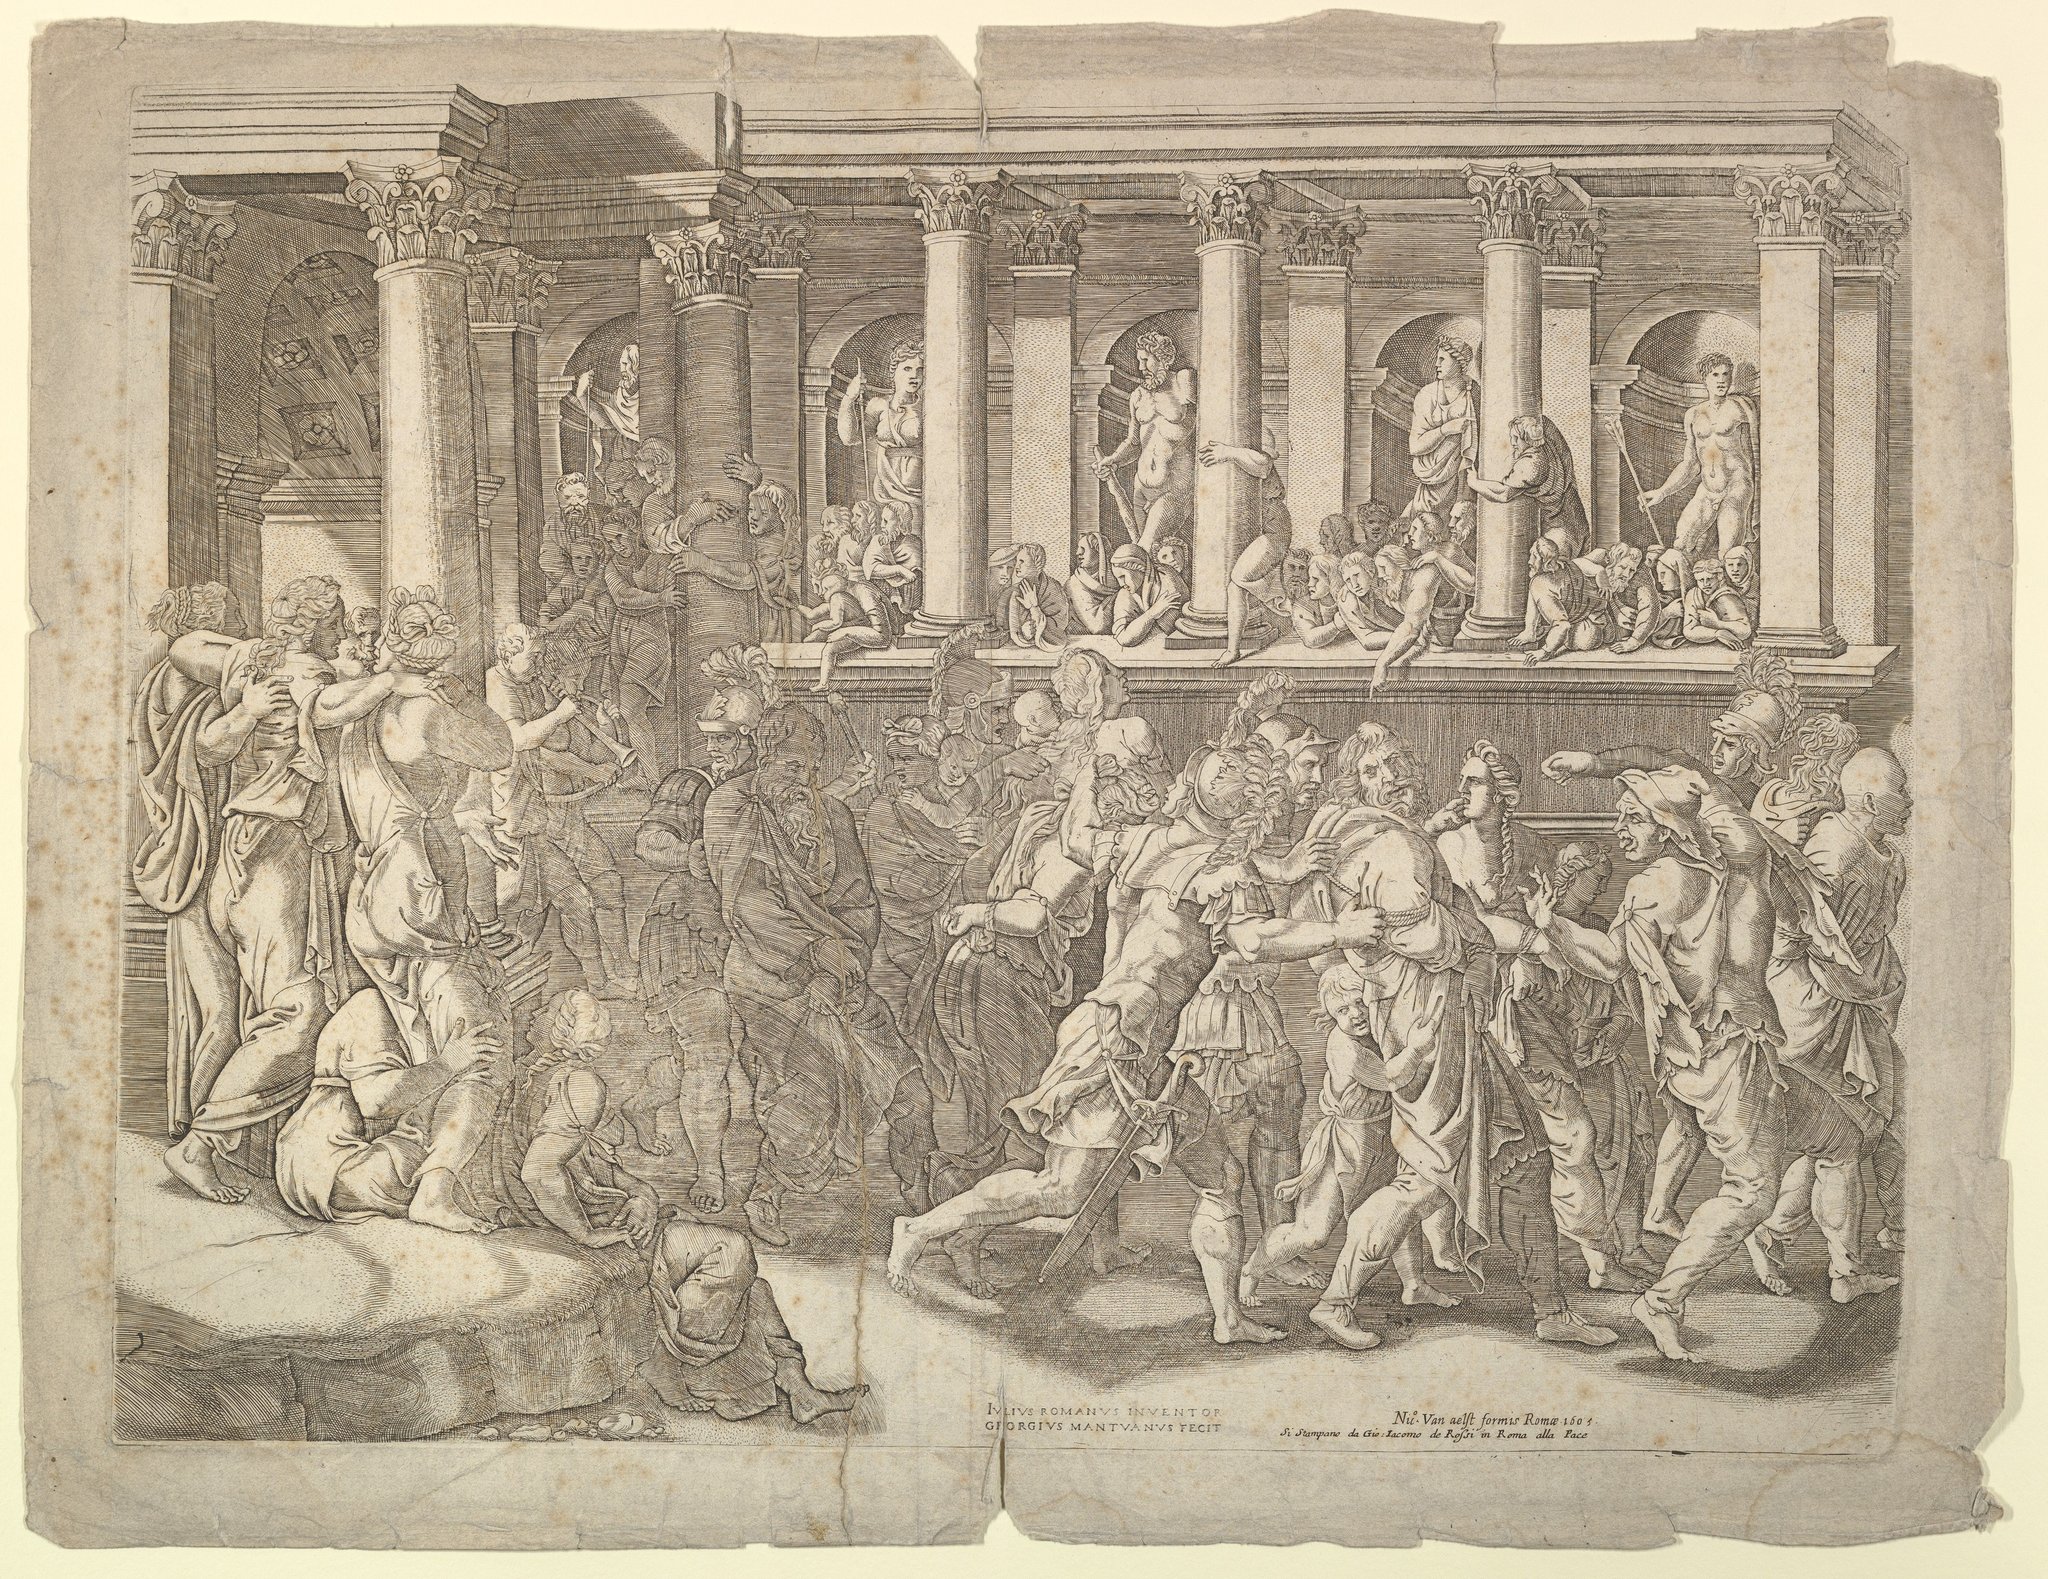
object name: print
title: The Mocking of the Prisoners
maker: giorgio ghisi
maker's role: artist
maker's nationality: italian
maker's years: 1515-1582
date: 1540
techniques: engraving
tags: prisoners,men,male nudes